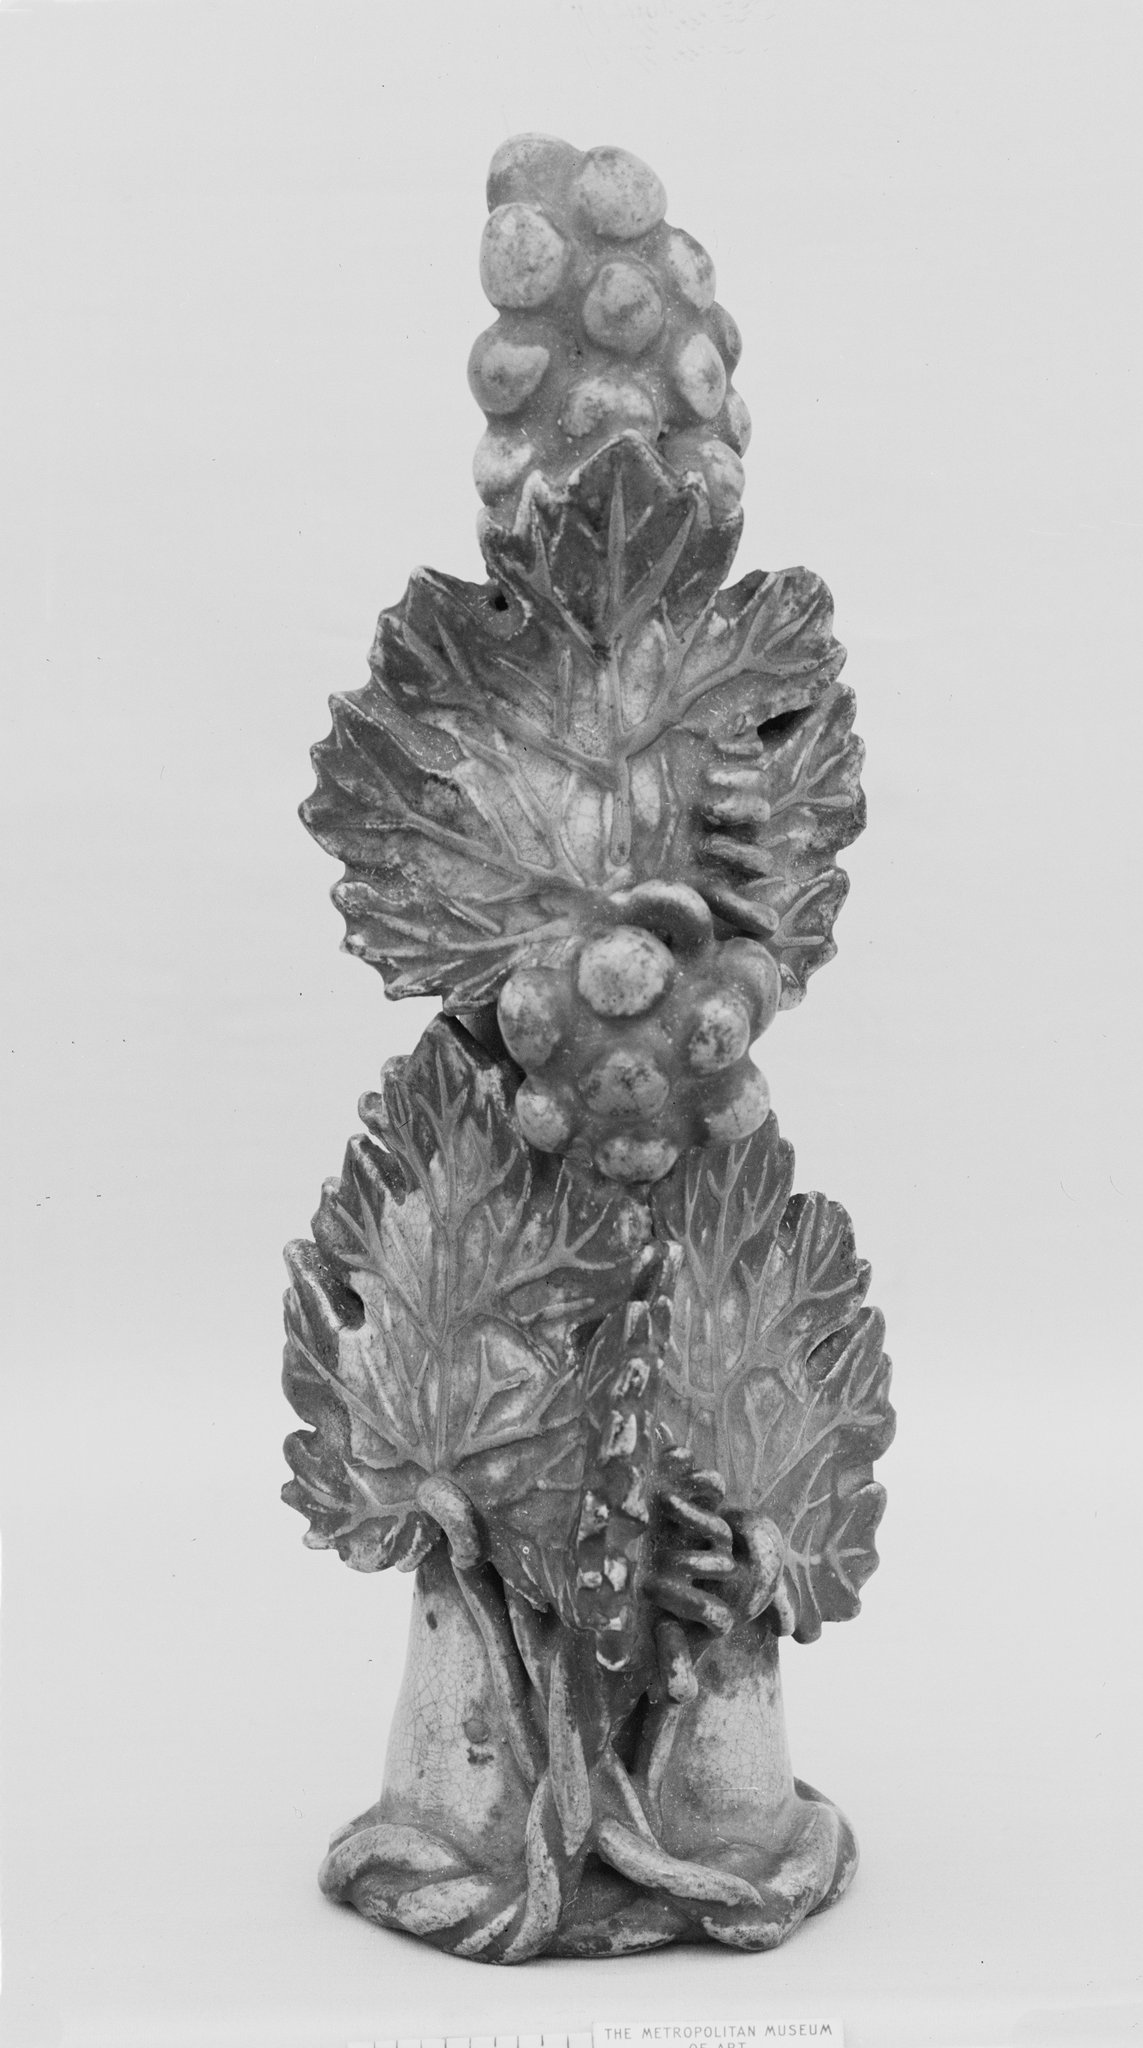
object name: hanging vase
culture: japanese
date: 1801-1900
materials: clay, enamel, glaze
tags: leaves